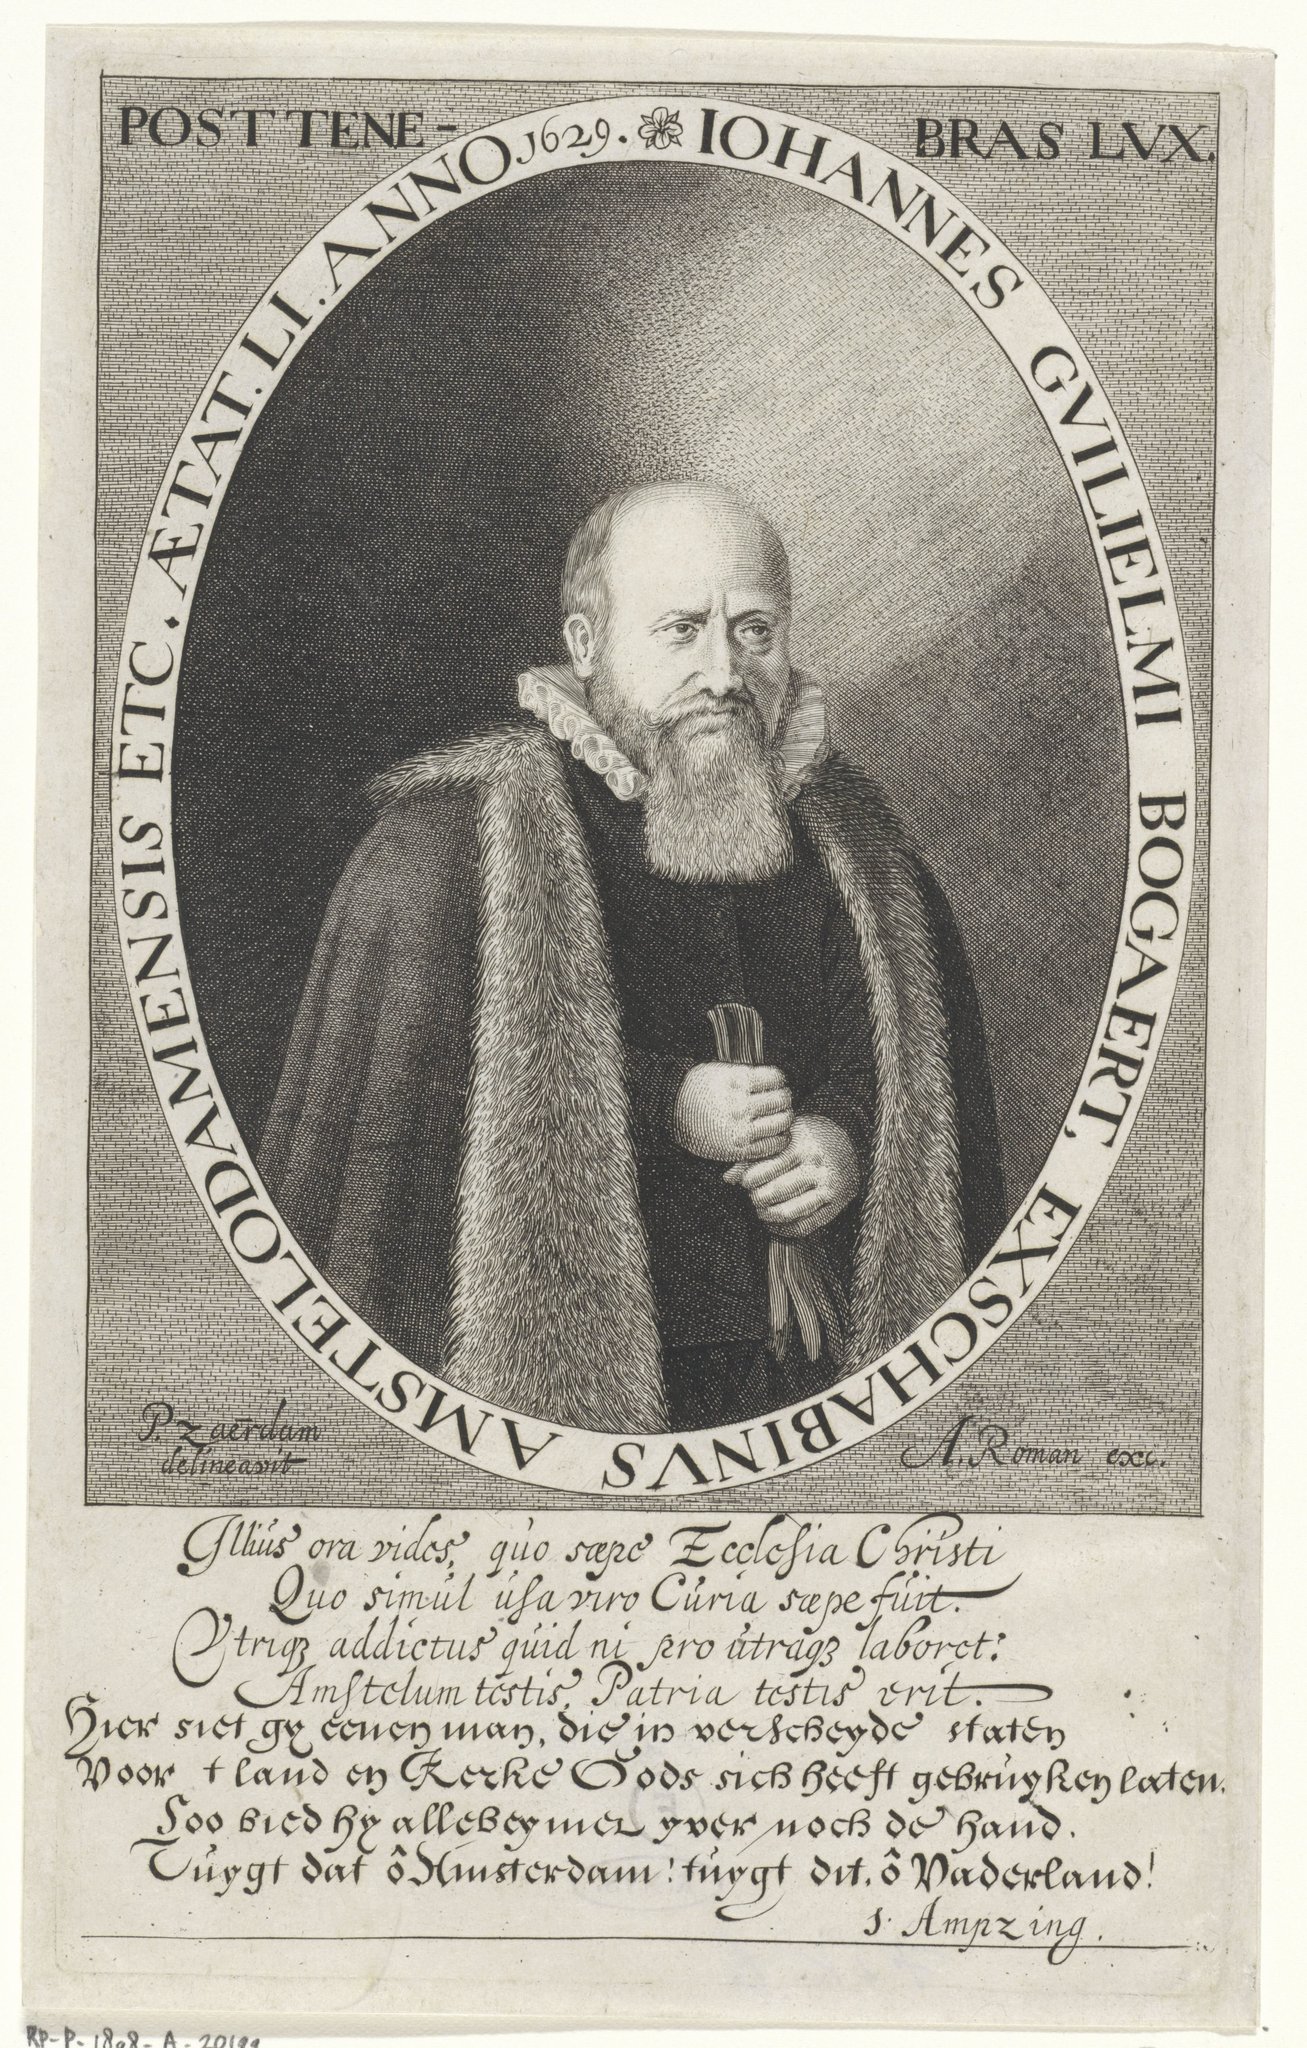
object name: print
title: Portret van Jan Willemsz Bogaert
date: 1629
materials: paper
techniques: engraving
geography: haarlem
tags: jan willemsz bogaert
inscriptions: collector's mark: Lugt 964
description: Portret van Jan Willemsz Bogaert, oud schepen van Amsterdam en verbannen wegens verzoekschrift tegen de Remonstranten.